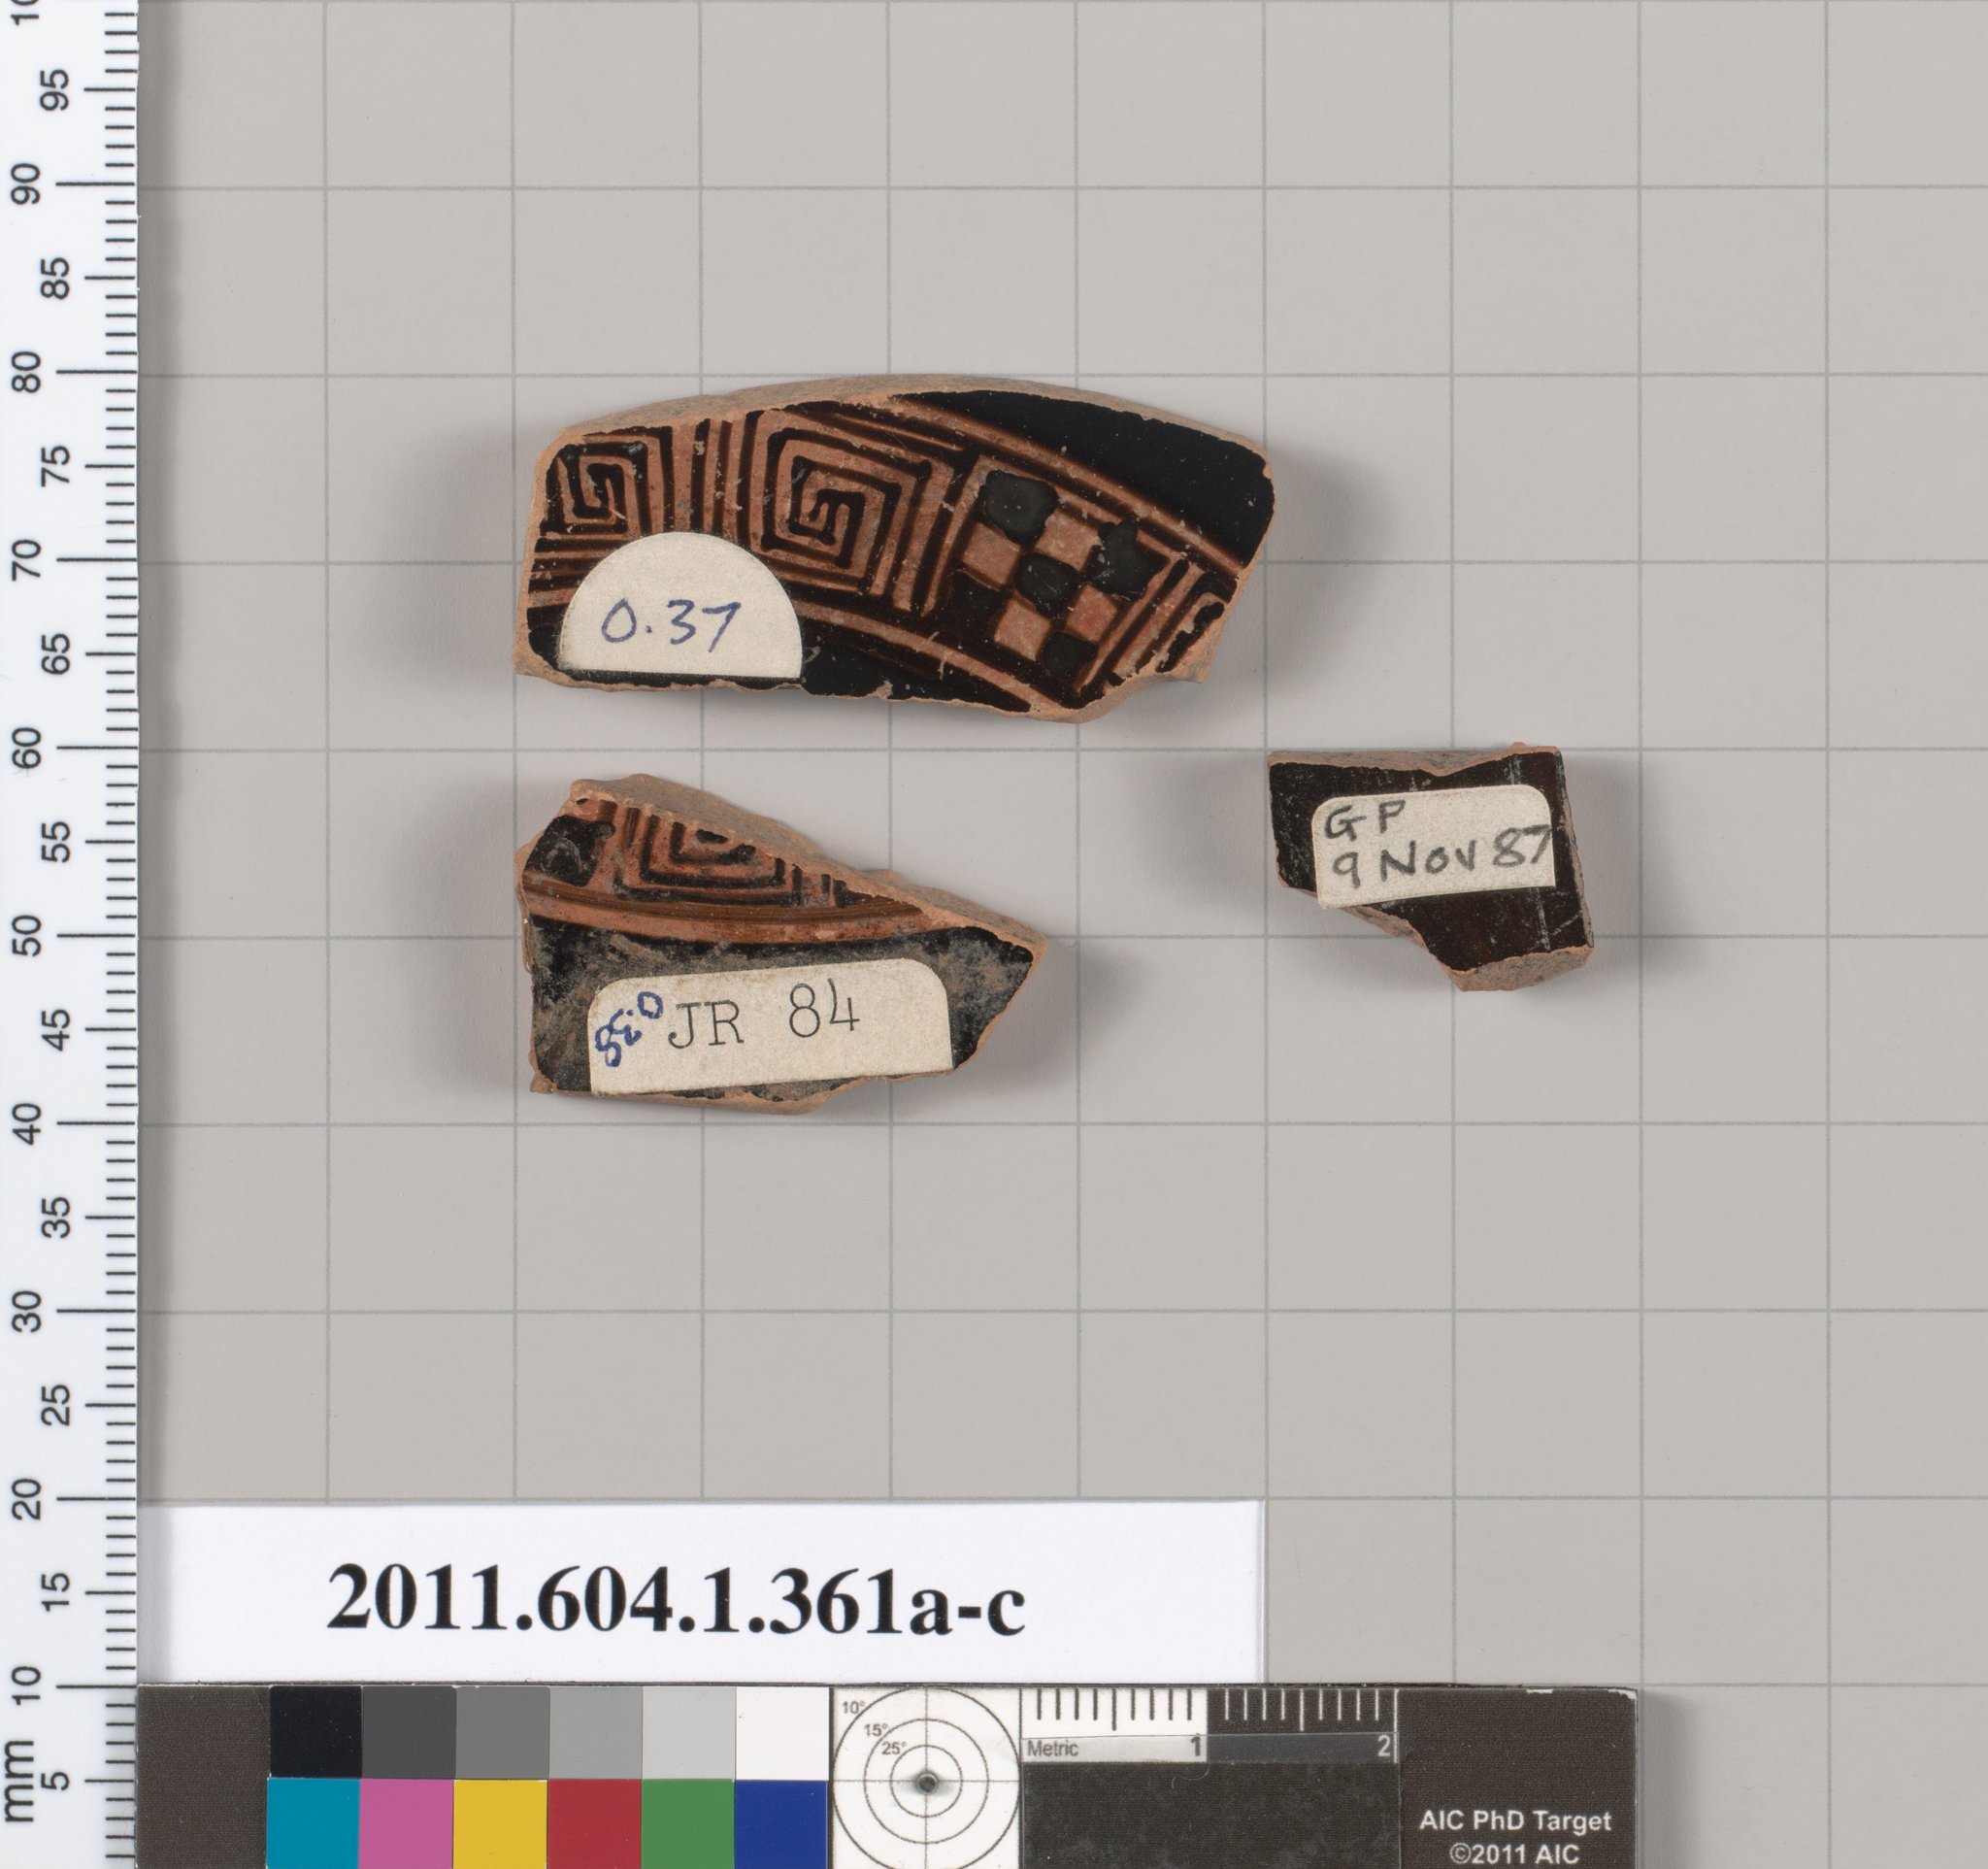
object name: kylix fragment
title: Terracotta fragments of kylikes (drinking cups)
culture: greek, attic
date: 475-451 BCE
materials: terracotta